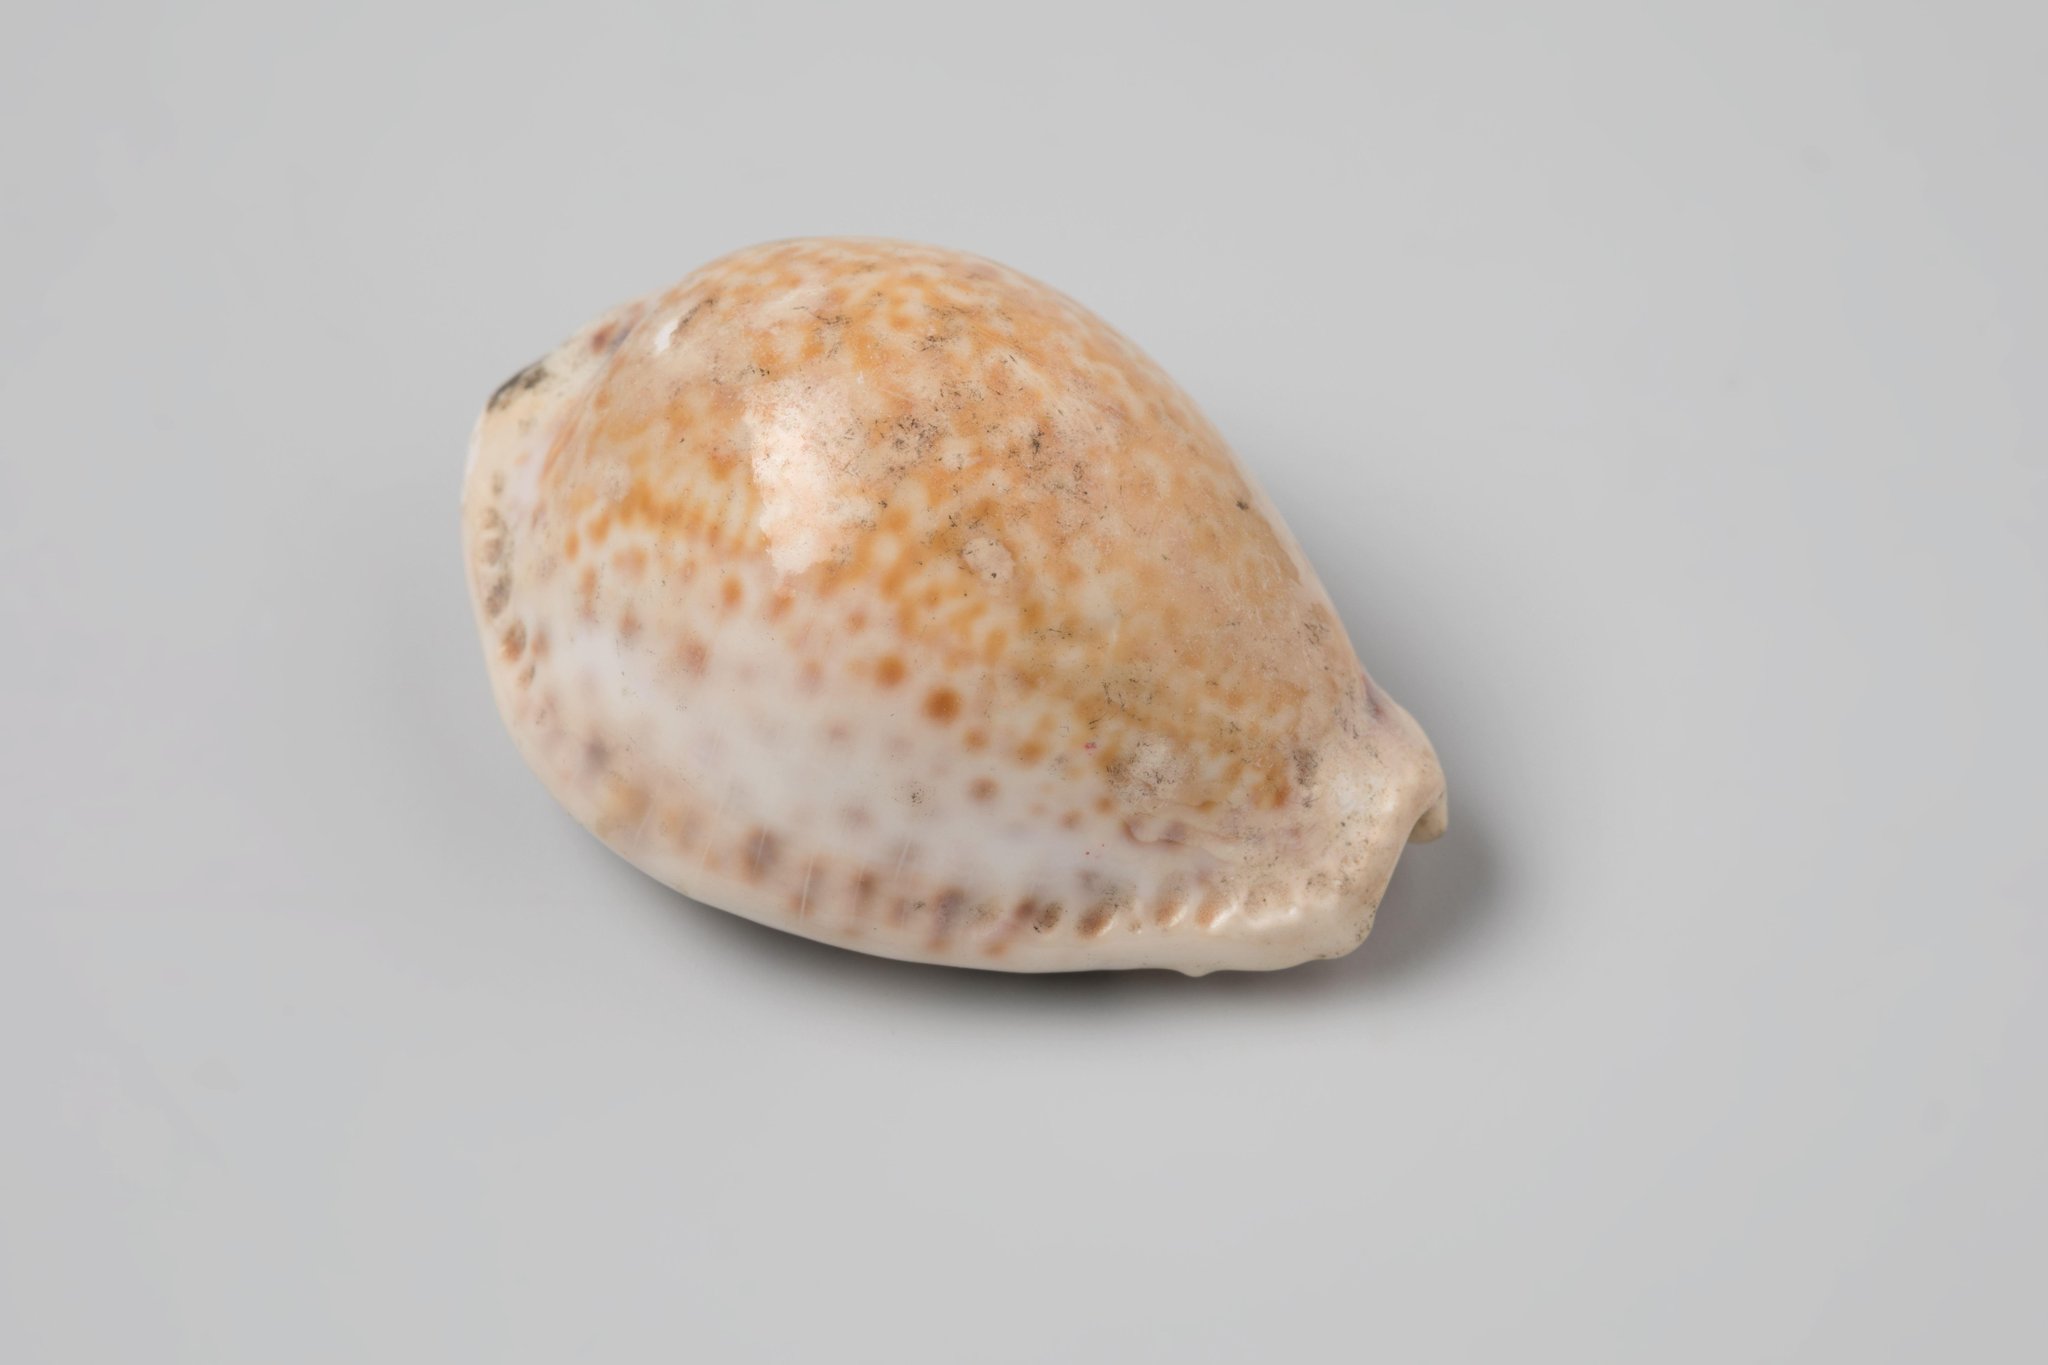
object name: erosaria spurca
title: Erosaria spurca shell from the wreck of the Dutch East India ship Witte Leeuw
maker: niet van toepassing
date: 1613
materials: shell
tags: verenigde oostindische compagnie, sint-helena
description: Schelp uit V.O.C.-schip de 'Witte Leeuw'.